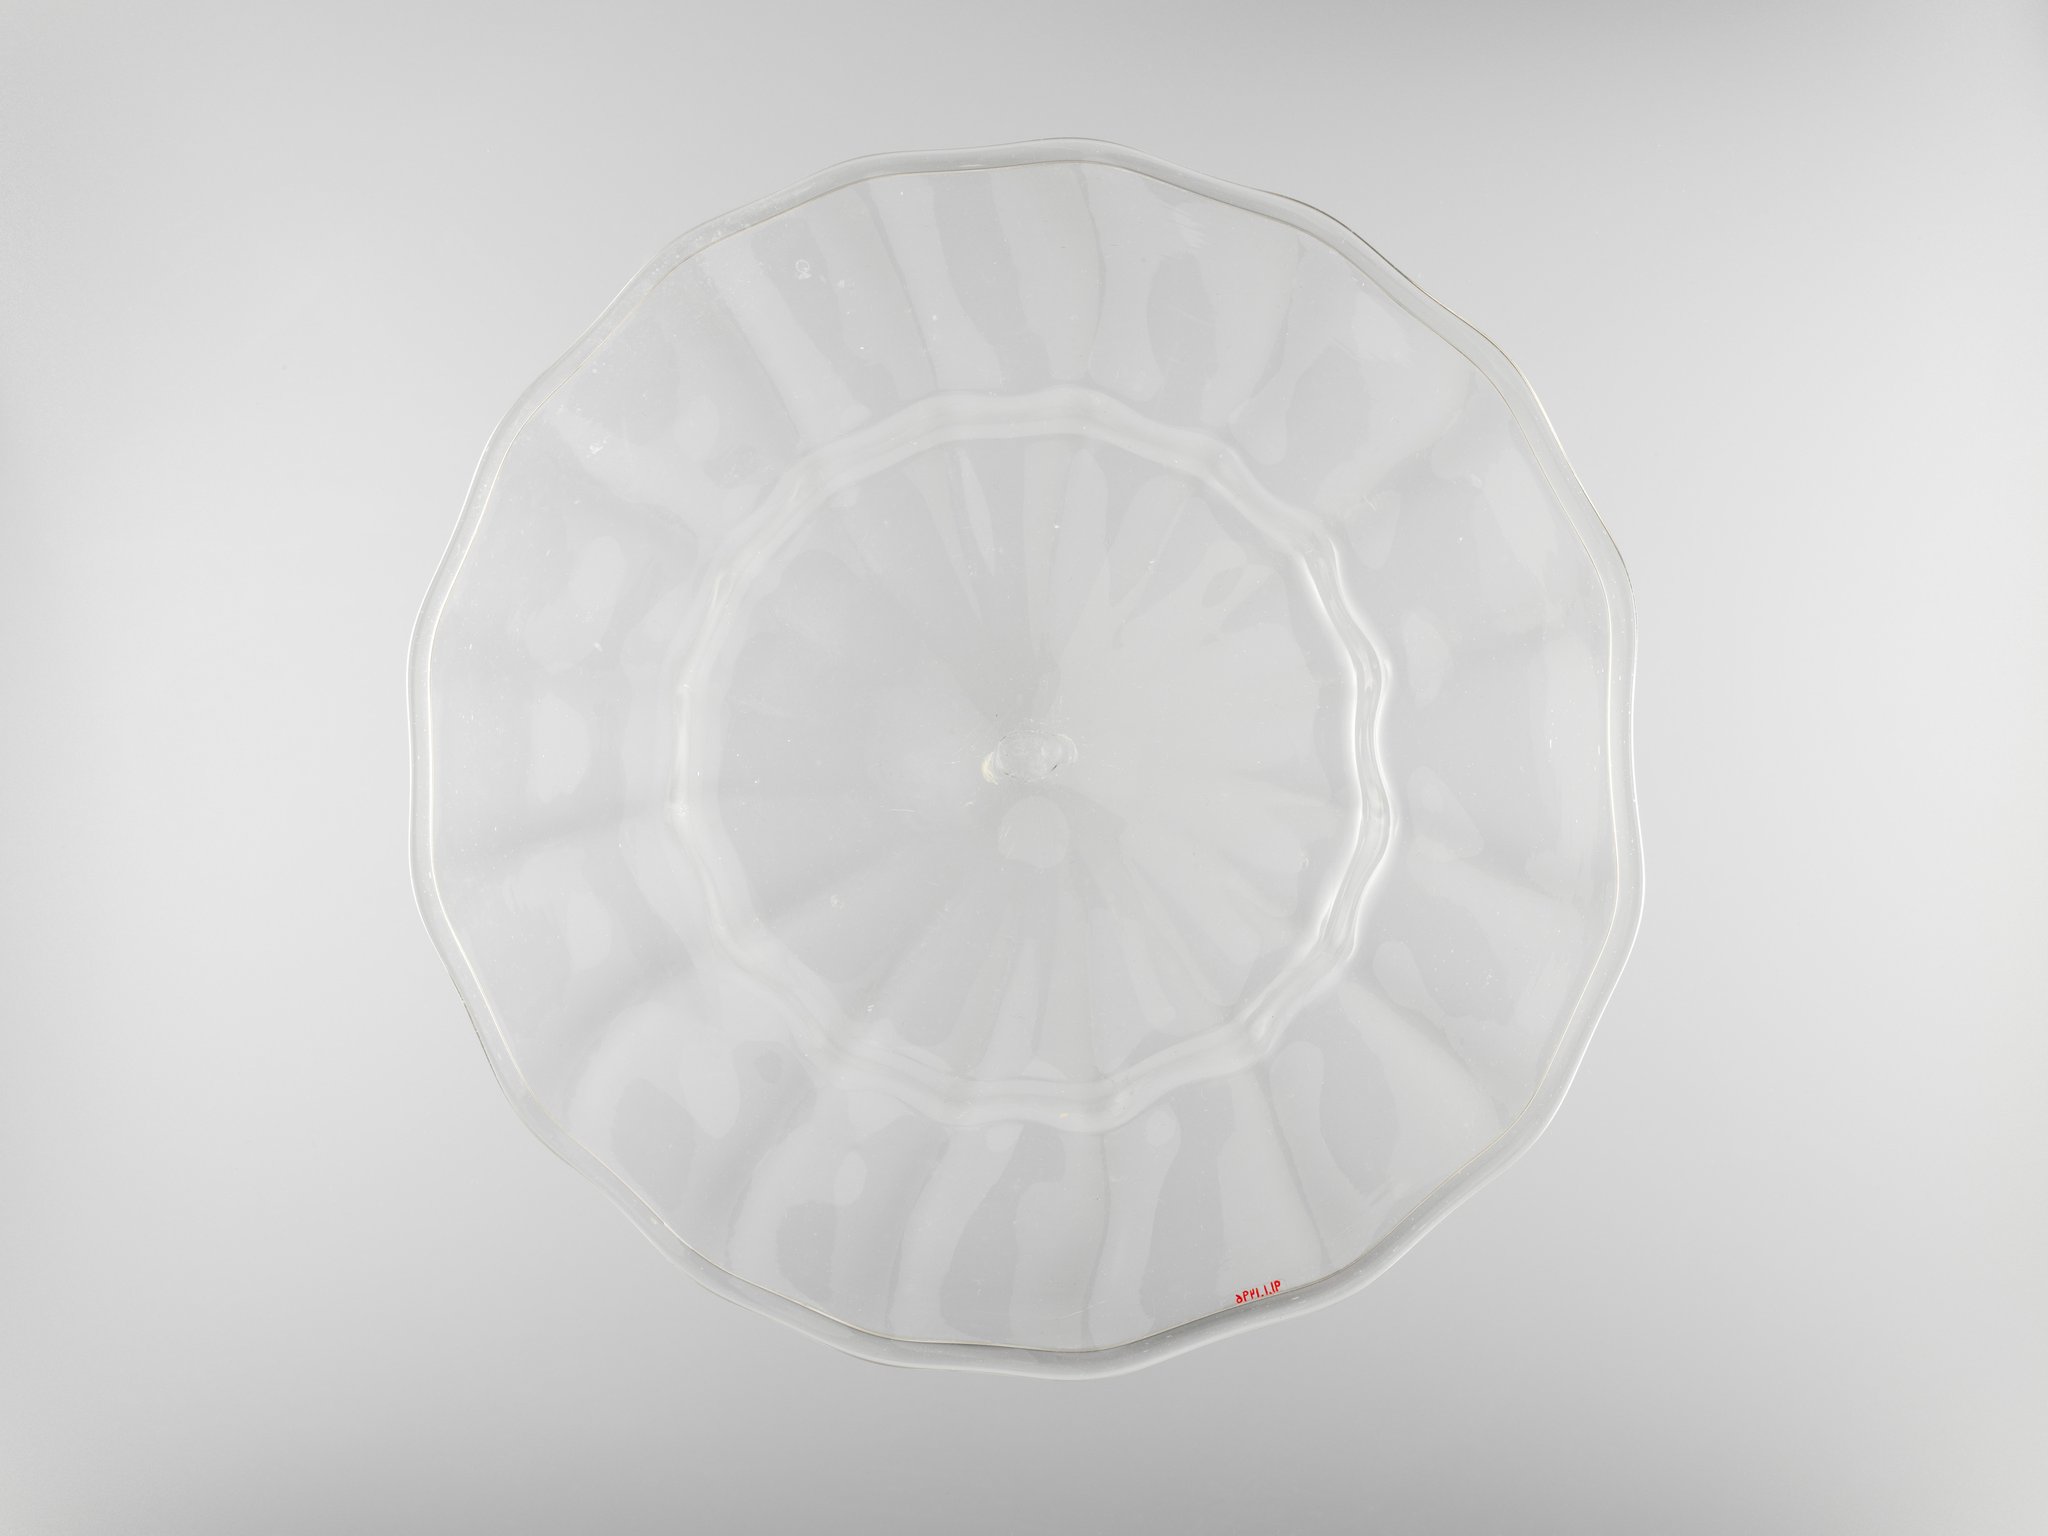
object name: plate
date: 1501-1700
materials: glass